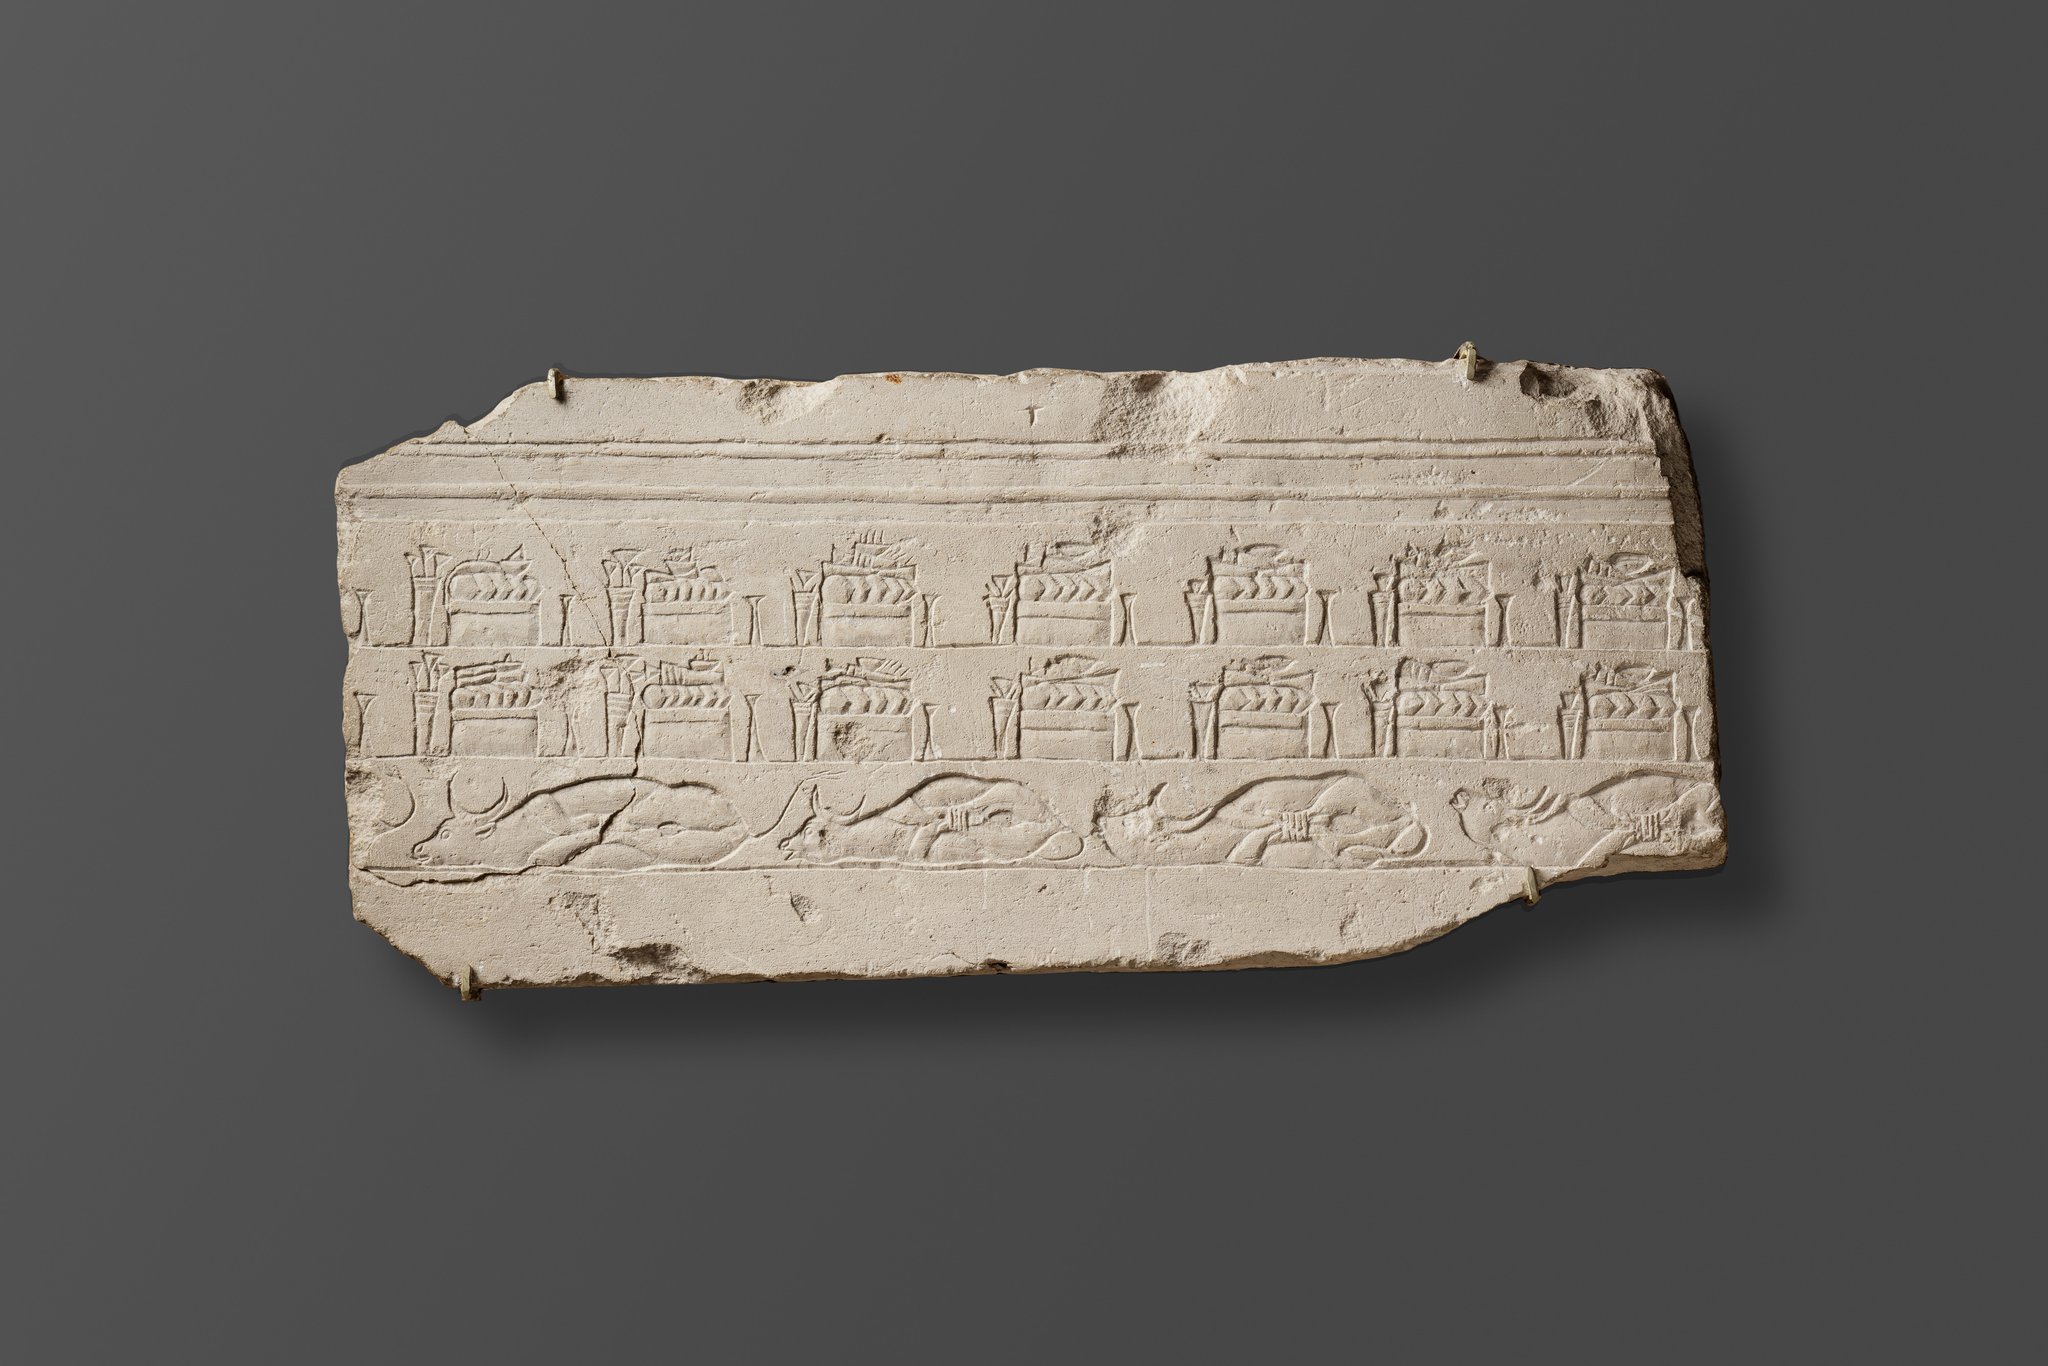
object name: talatat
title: Talatat with Offerings in the Temple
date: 1353-1336 BCE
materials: limestone, paint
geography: egypt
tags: animals